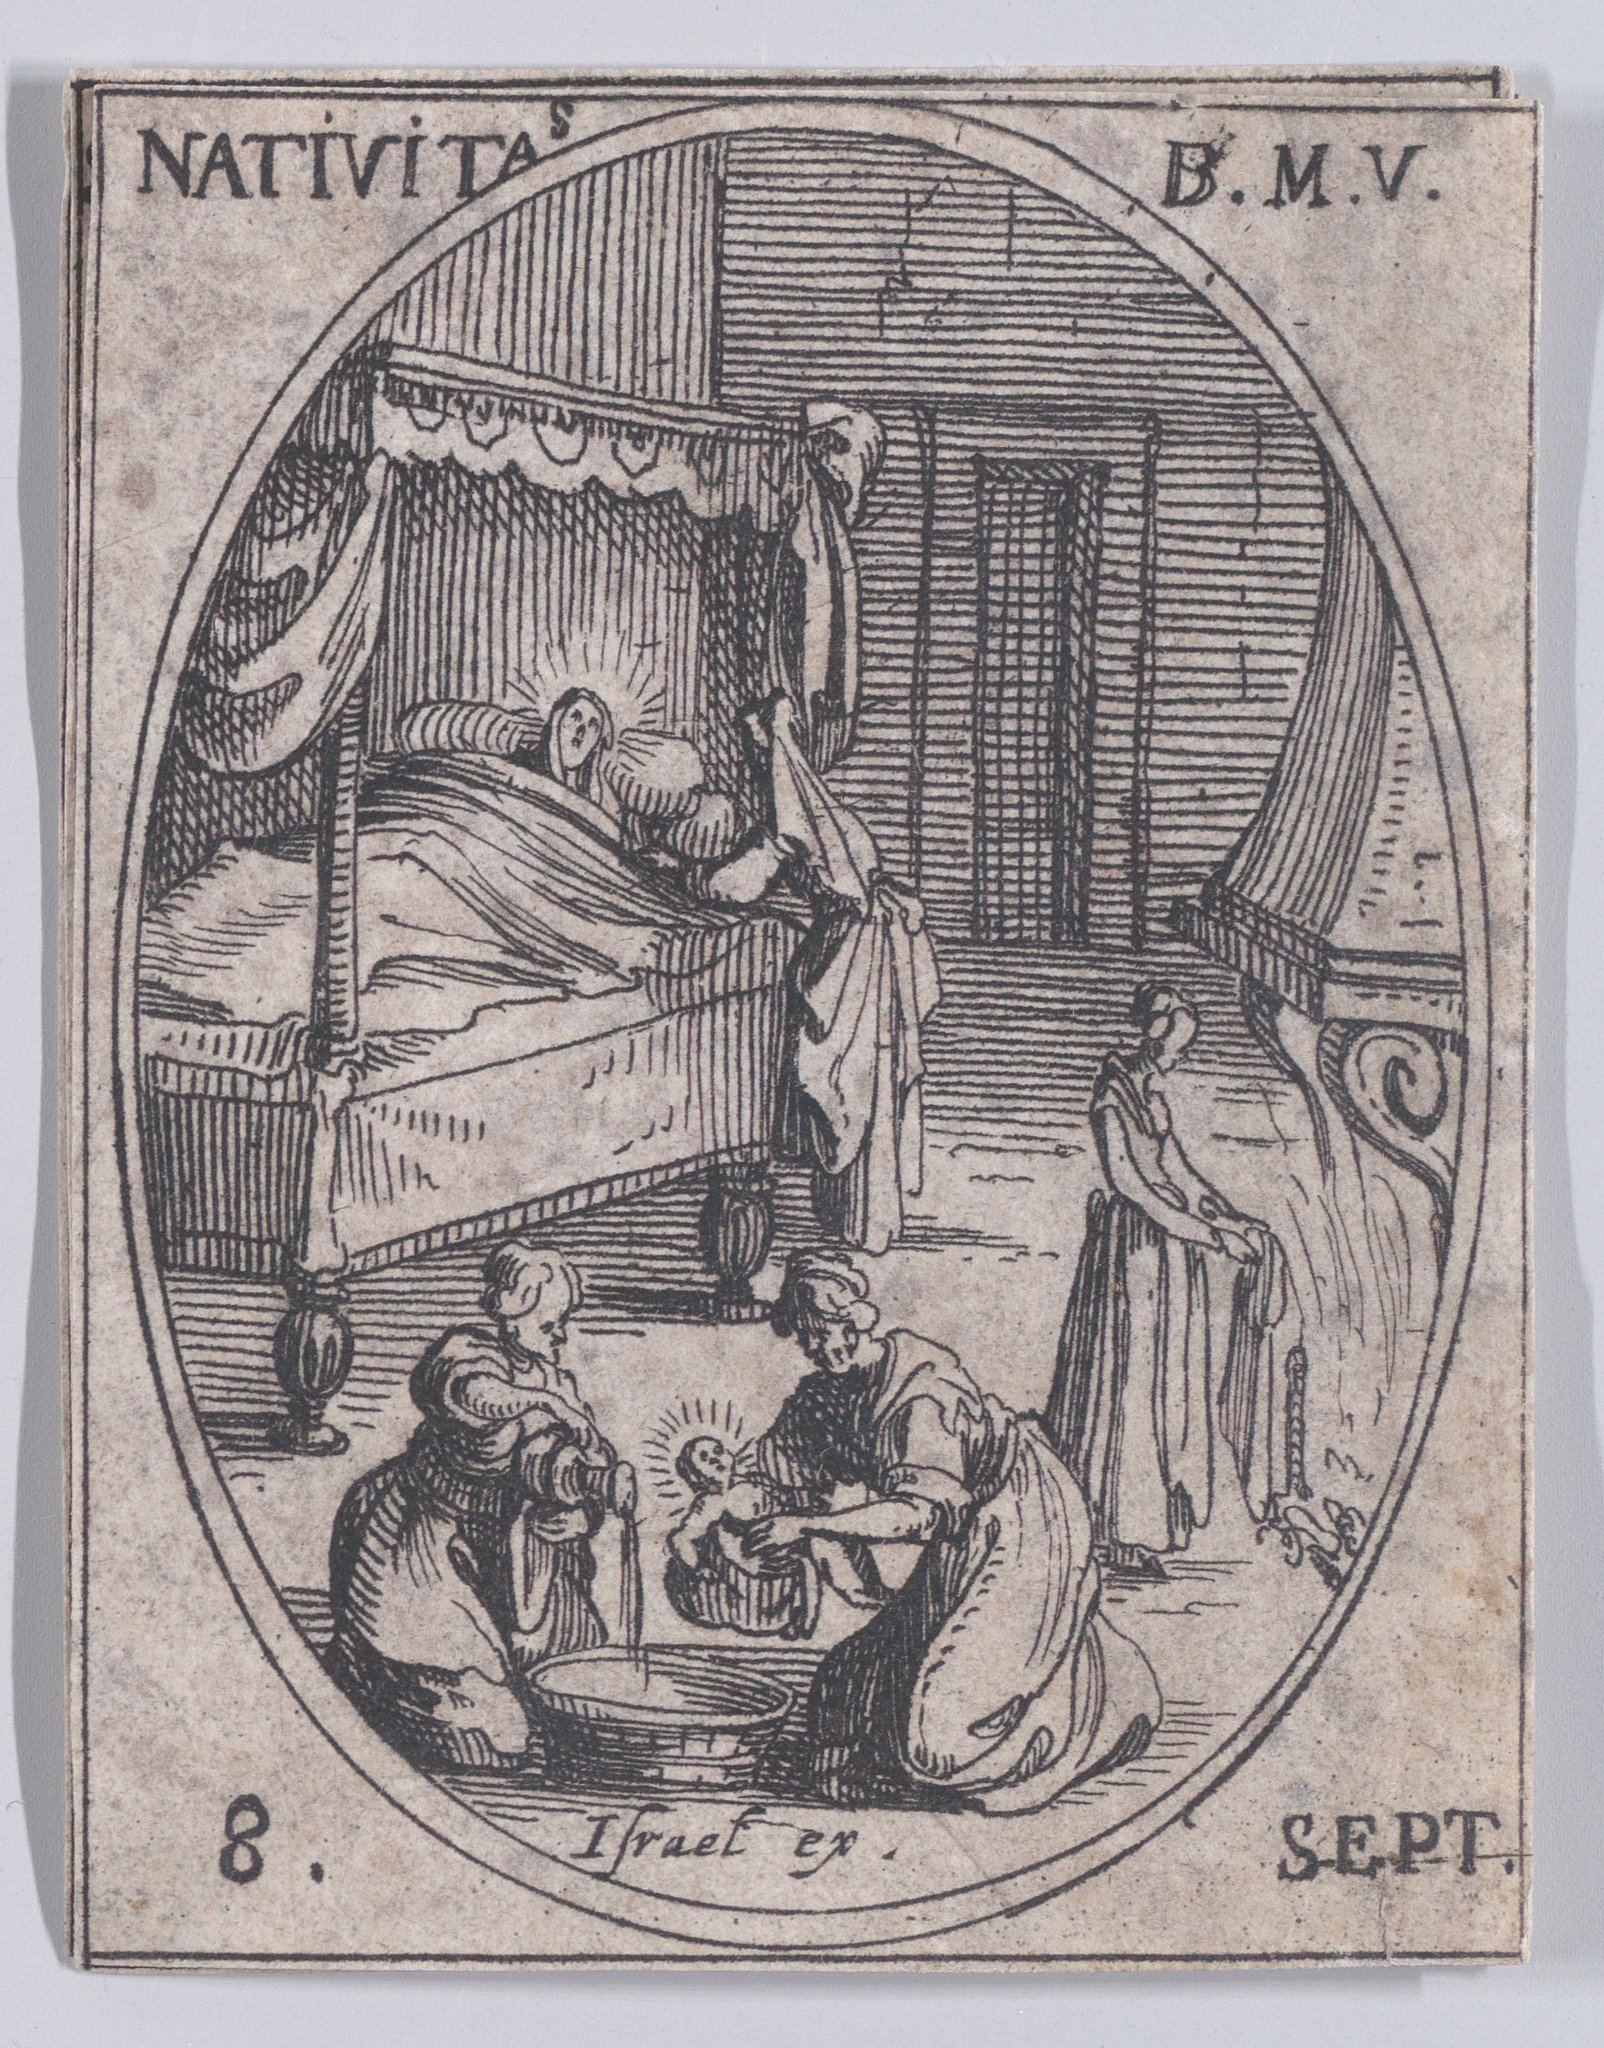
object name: print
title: La Nativité de la Sainte Vierge (The Birth of the Virgin), September 8th, from "Les Images De Tous Les Saincts et Saintes de L'Année" (Images of All of the Saints and Religious Events of the Year)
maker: jacques callot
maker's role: artist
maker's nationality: french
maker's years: 1592-1635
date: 1636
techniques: etching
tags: infants,women,virgin mary,beds